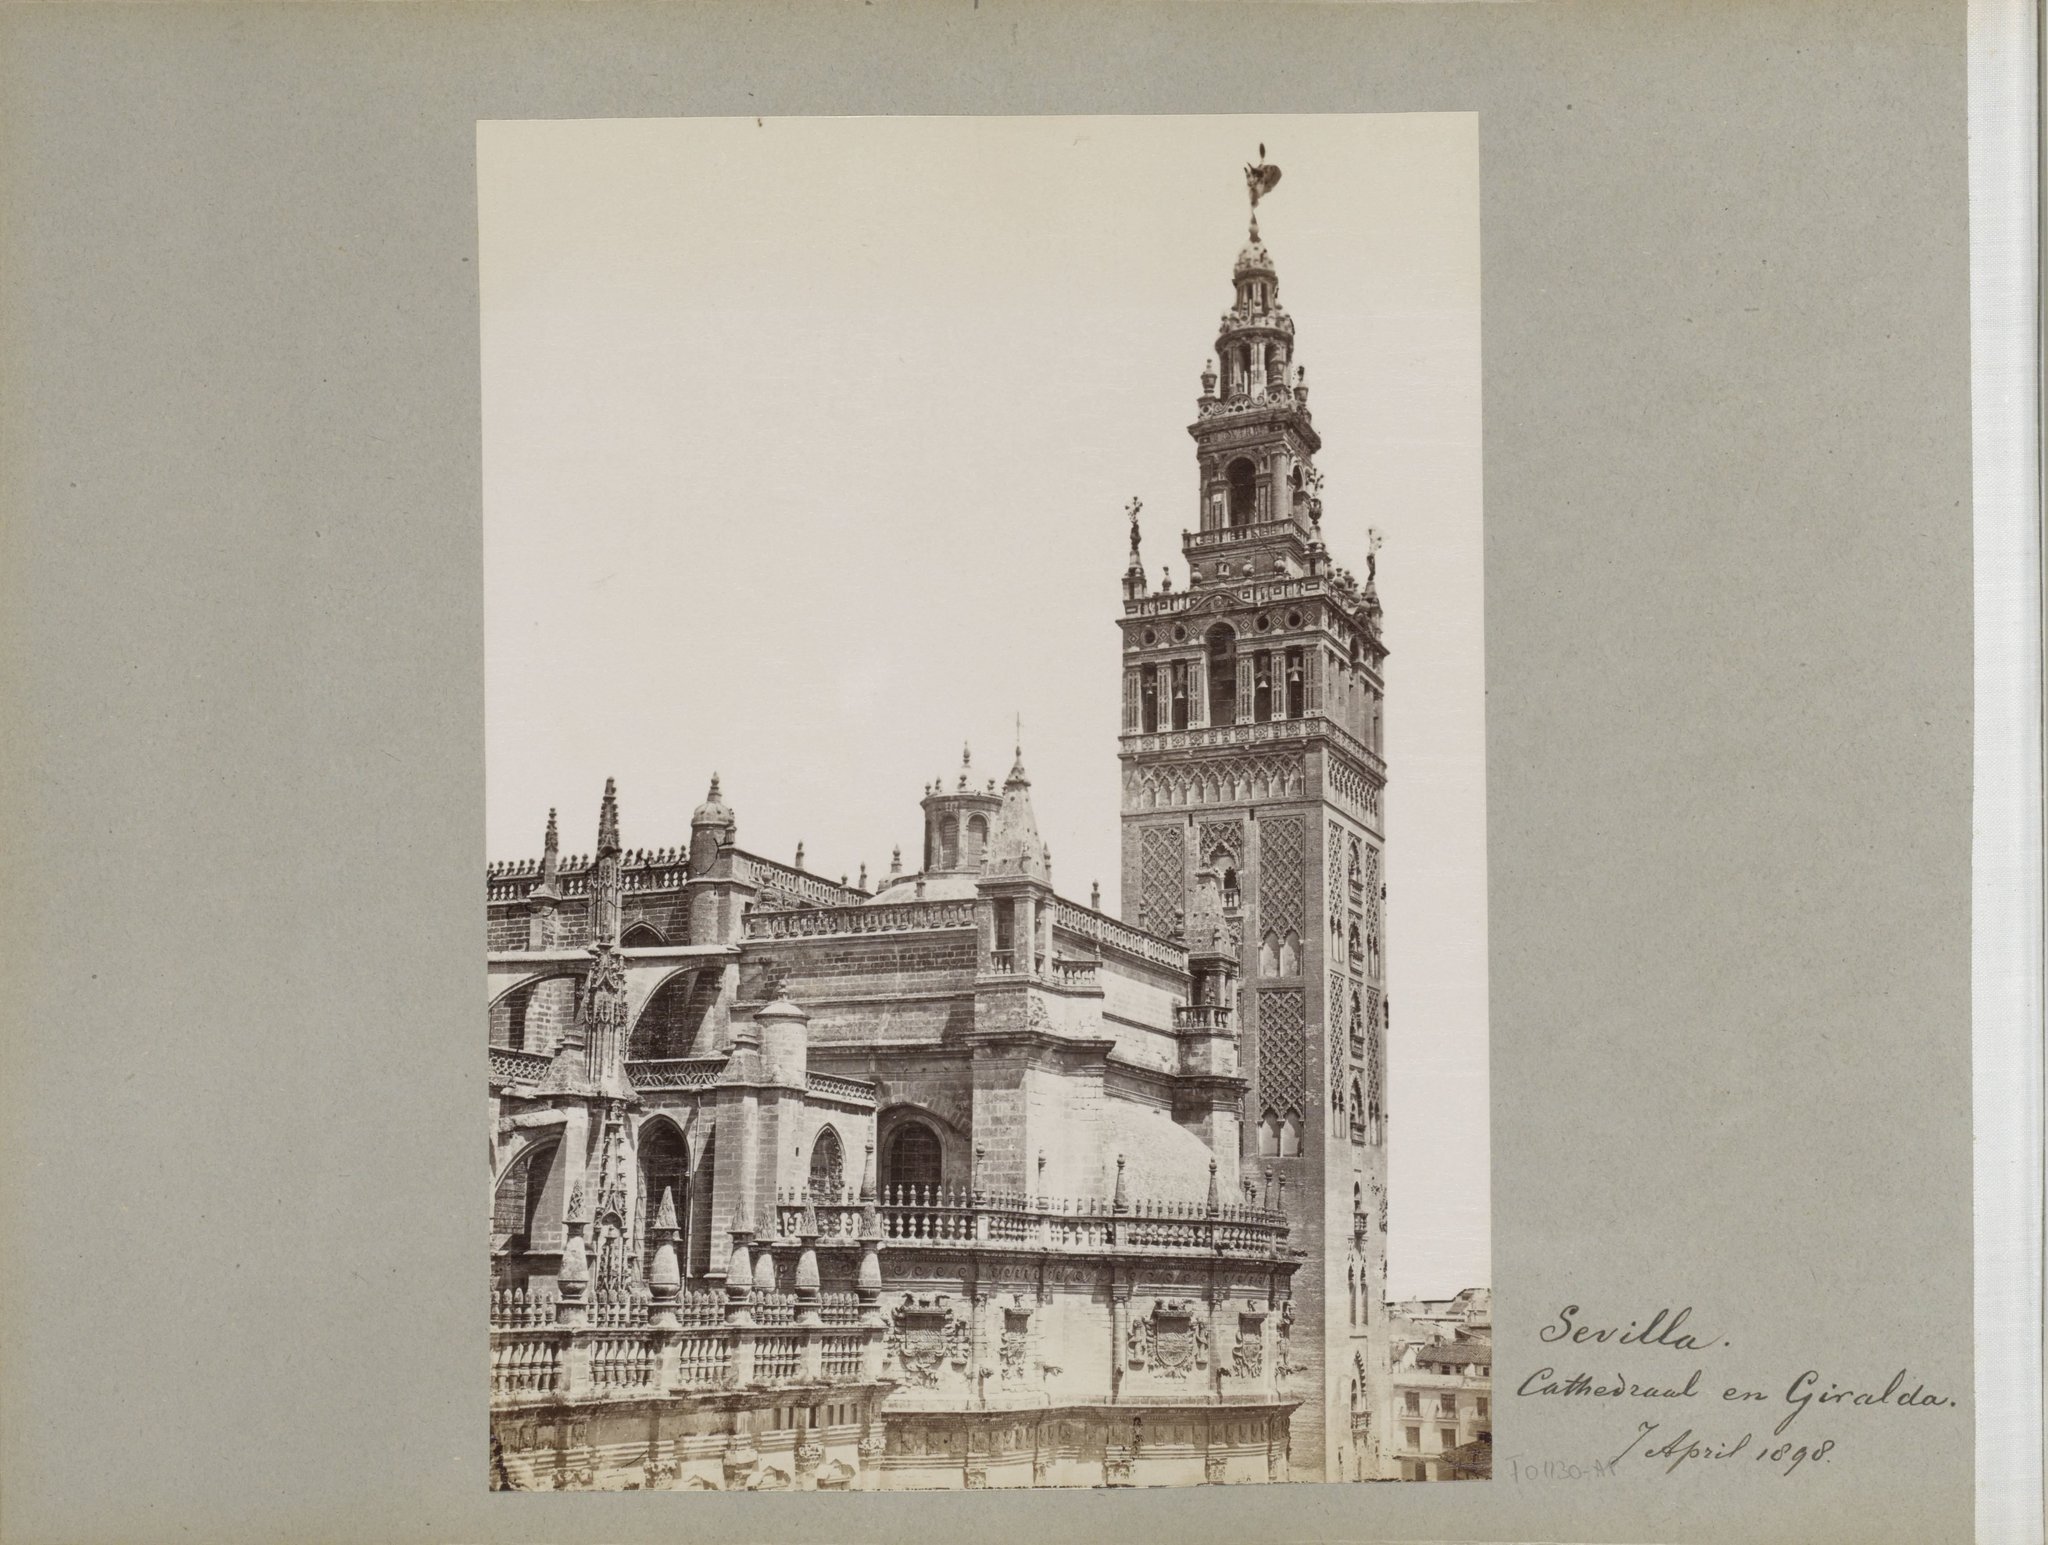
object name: photograph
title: Kathedraal van Sevilla met rechts de Giralda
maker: Anonymous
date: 1880-1898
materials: paper, photographic support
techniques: albumen print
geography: sevilla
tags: tower, clock tower ~ monumental adornment, church (exterior), sevilla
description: Onderdeel van Reisalbum met foto's van bezienswaardigheden in Frankrijk, Spanje, Italië, Duitsland, Zwitserland en Oostenrijk.